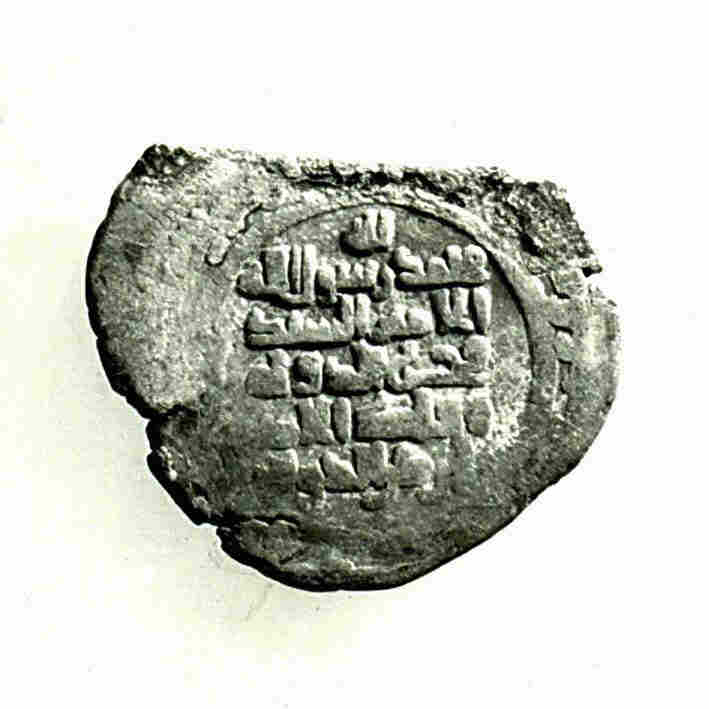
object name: coin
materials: silver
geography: jurjan